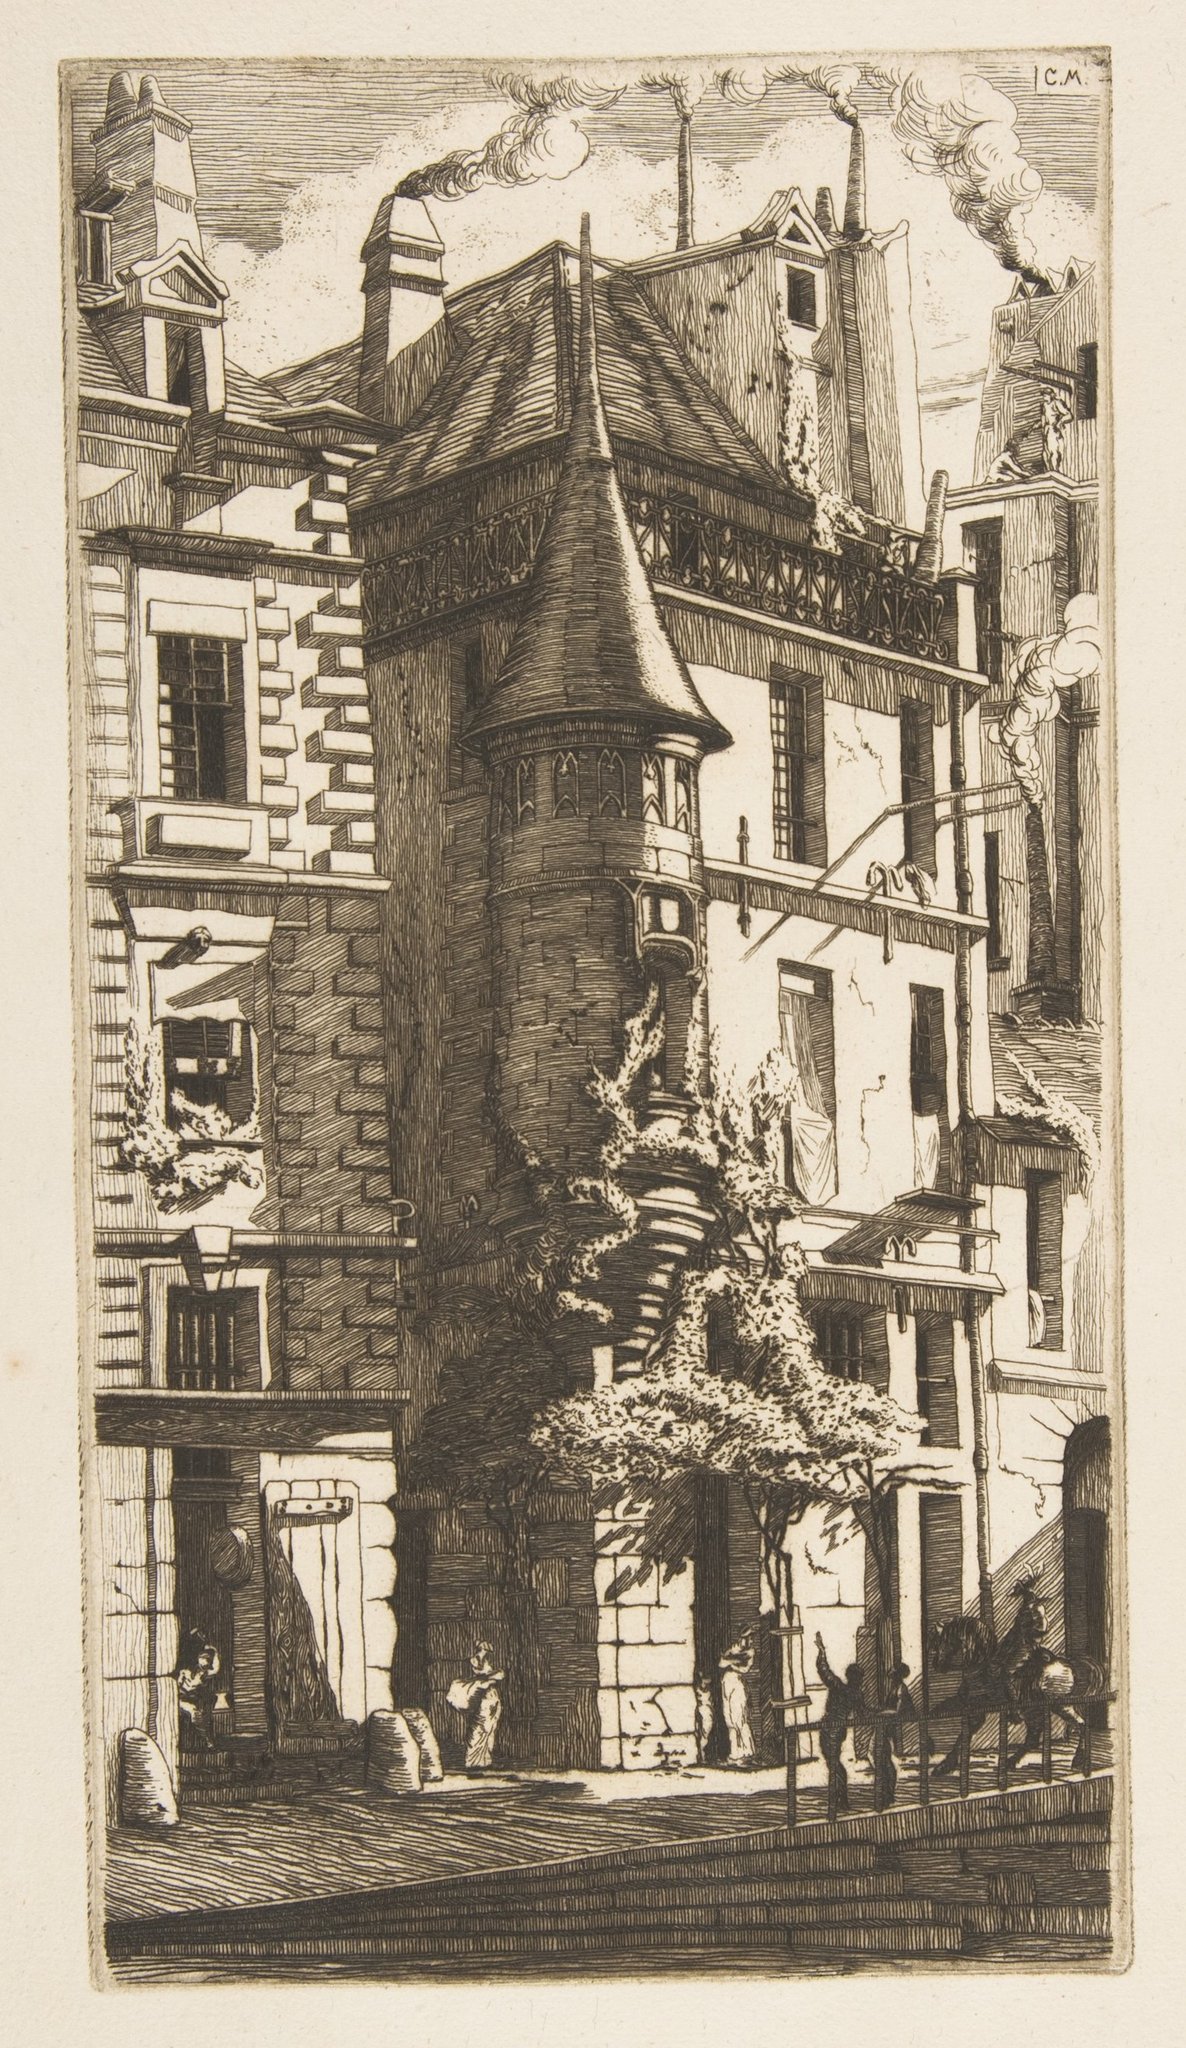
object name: print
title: House with a Turret, rue de la Tixéranderie, Paris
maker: edmond gosselin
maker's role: artist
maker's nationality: french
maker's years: 1881-1912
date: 1881-1882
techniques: etching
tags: houses,towers,paris